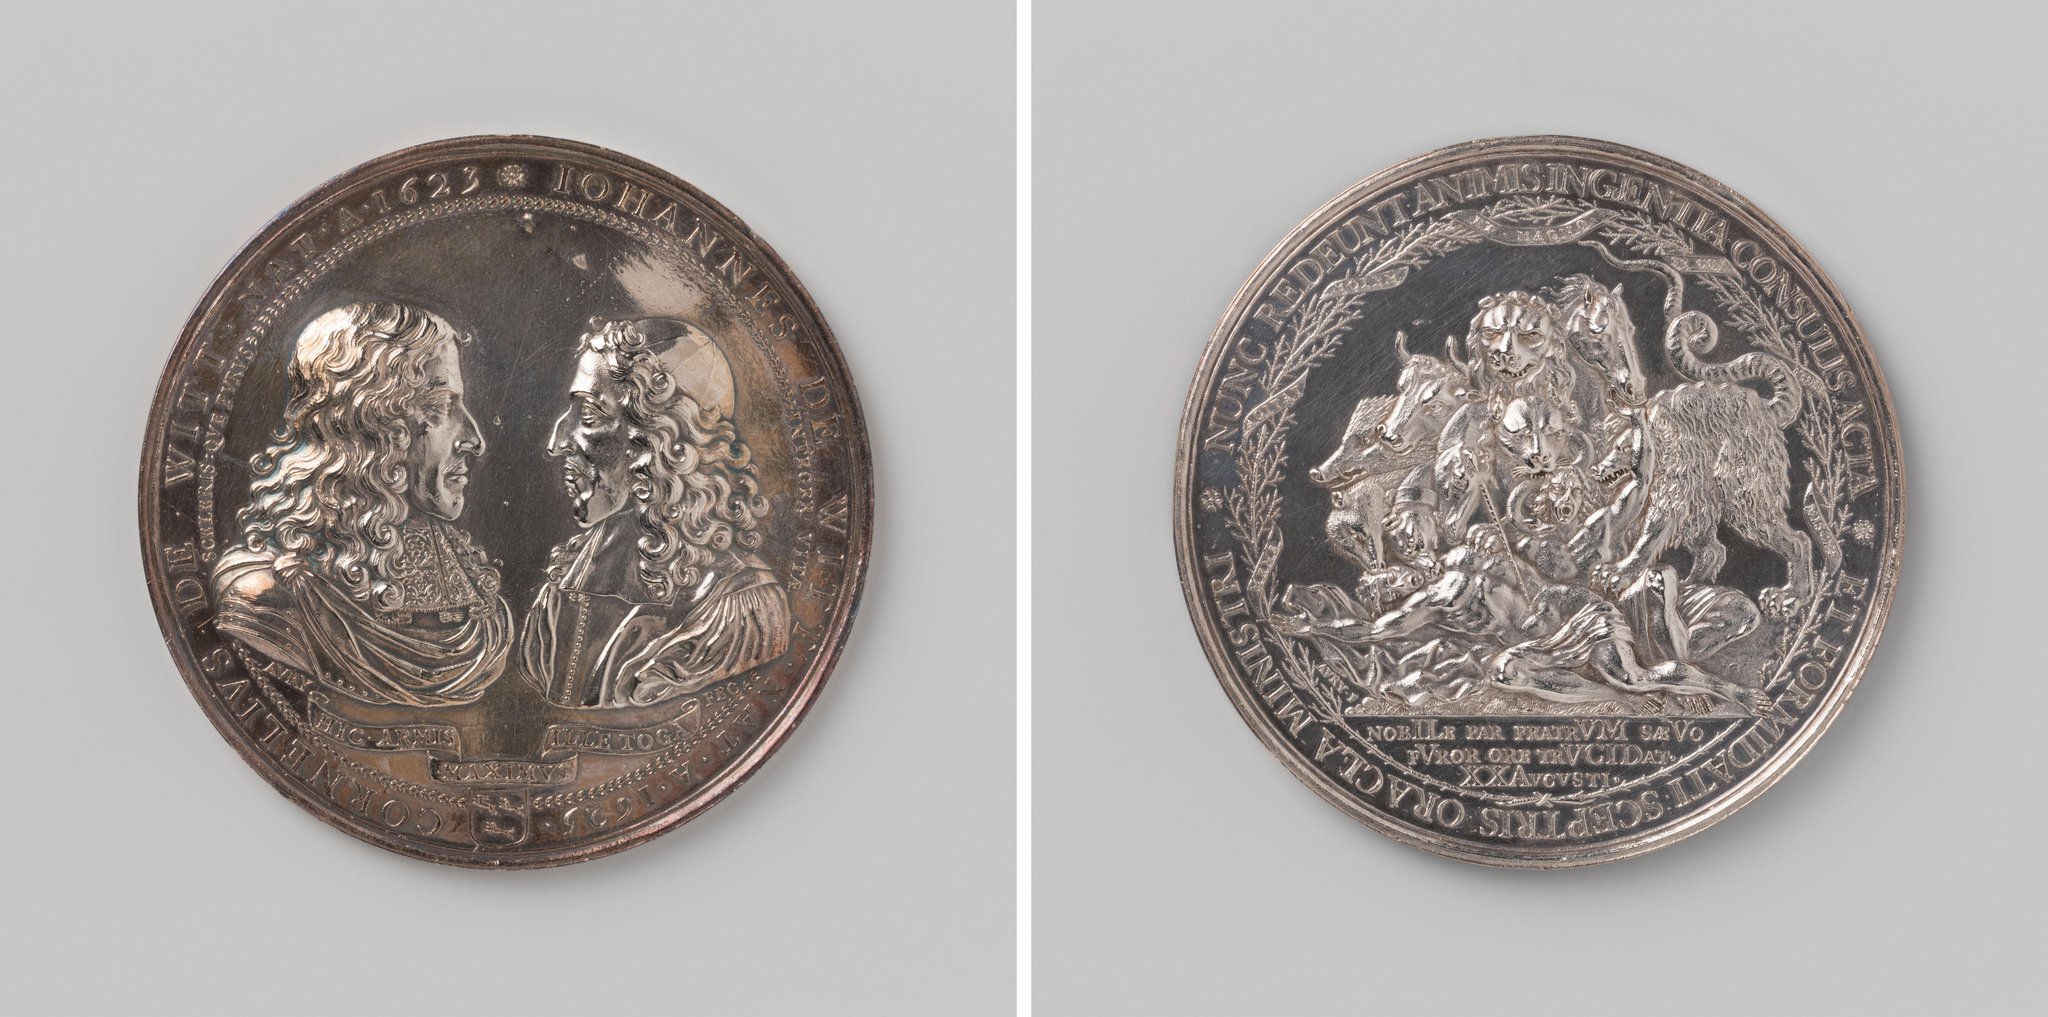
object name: history medal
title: Moord op de gebroeders de Witt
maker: pierre aury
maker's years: 1622-1692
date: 1672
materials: ink, paper, silver, wood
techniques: striking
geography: netherlands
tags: dordrecht, cornelis de witt, the hague, politician, johan de witt, netherlands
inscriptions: circumscription: ‘SCELERIS QVE PVRVS INTEGER VITÆ’, circumscription: ‘NUNC REDEUNT ANIMIS INGENTIA CONSULIS ACTA ET FORMIDATI SCEPTRIS ORACLA MINISTRI’, caption: ‘NOBILE PAR FRATRUM SÆ VO FUROR ORE TRUGIO AT XX AUGUSTI’, poem: ‘OP DE HELDEN-BEELDEN... OP DE BEESTELYKE WOEDE...’, circumscription: ‘MENS AGITAT MOLEN ET MAGNO SE COR PORA MISCET’, circumscription: ‘CORNELIUS DE WITT NAT A1623 IOHANNUS DE WITT NAT A1625’, caption: ‘HIC ARMIS MAXIMVS ILLETOGA’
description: Zilveren gedenkpenning op de moord op Johan en Cornelis de Witt. Voorzijde: binnen omschrift de busten van de gebroeders, waaronder een banderol met opschrift. Keerzijde: binnen omschrift twee naakte mannen door wilde dieren verscheurd, waaronder opschrift. In rond houten doosje. Met bijbehorende doos NG-NM-5354-2.